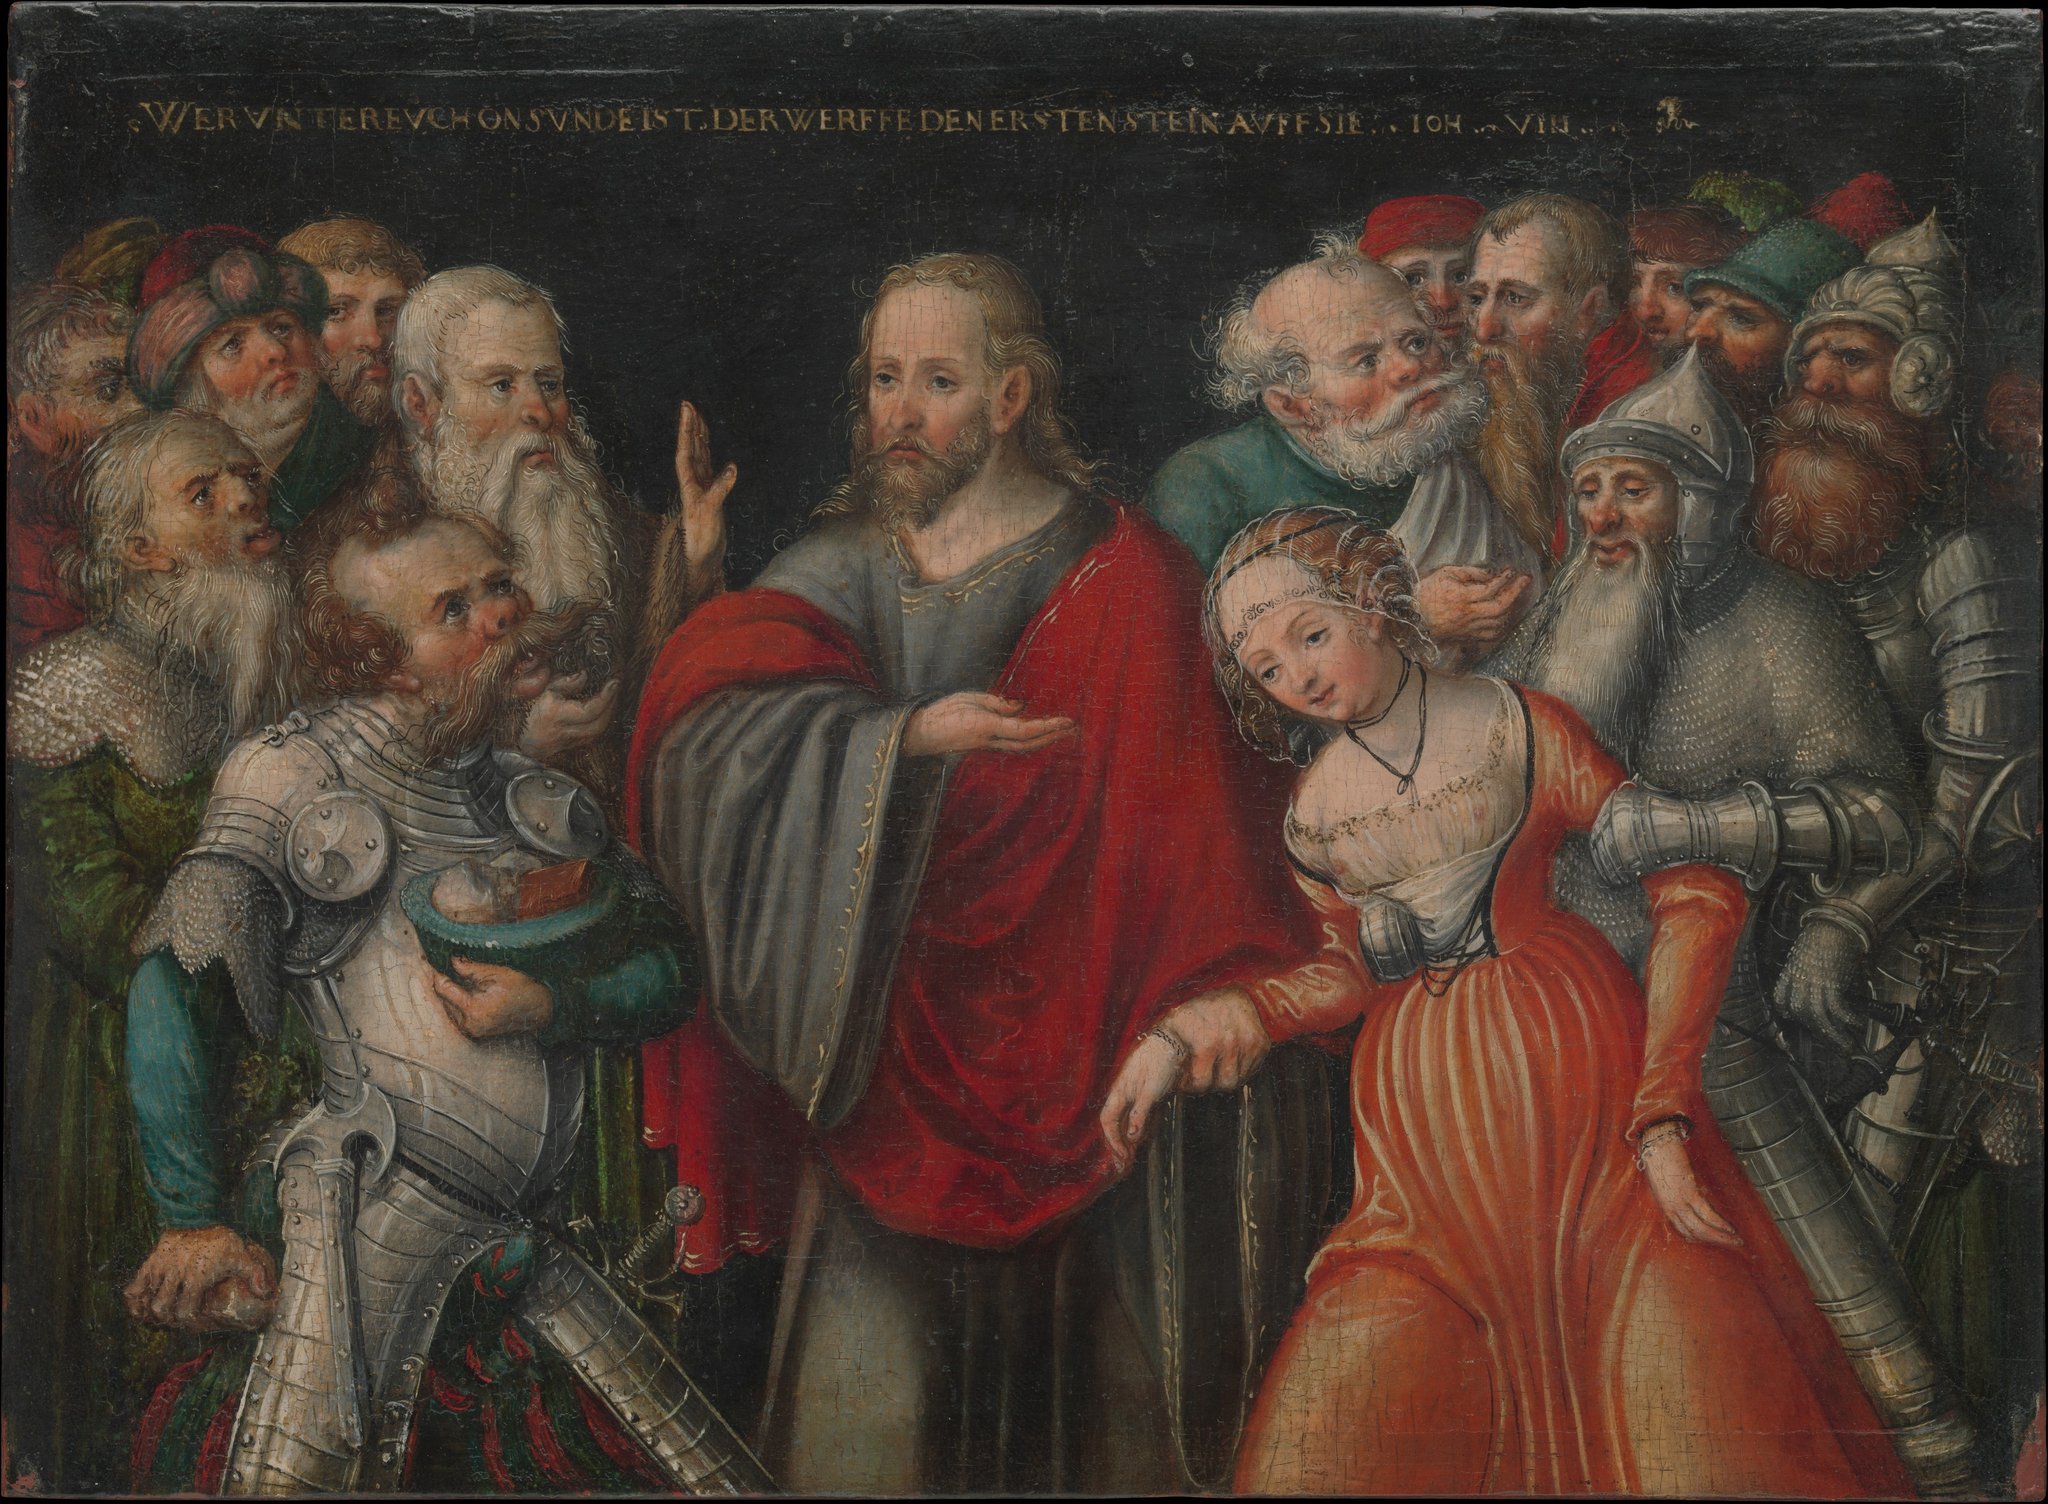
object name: painting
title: Christ and the Adulteress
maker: lucas cranach the younger and workshop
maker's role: artist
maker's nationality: german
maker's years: 1515-1586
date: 1545-1550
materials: wood, oil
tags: soldiers,armor,men,women,christ